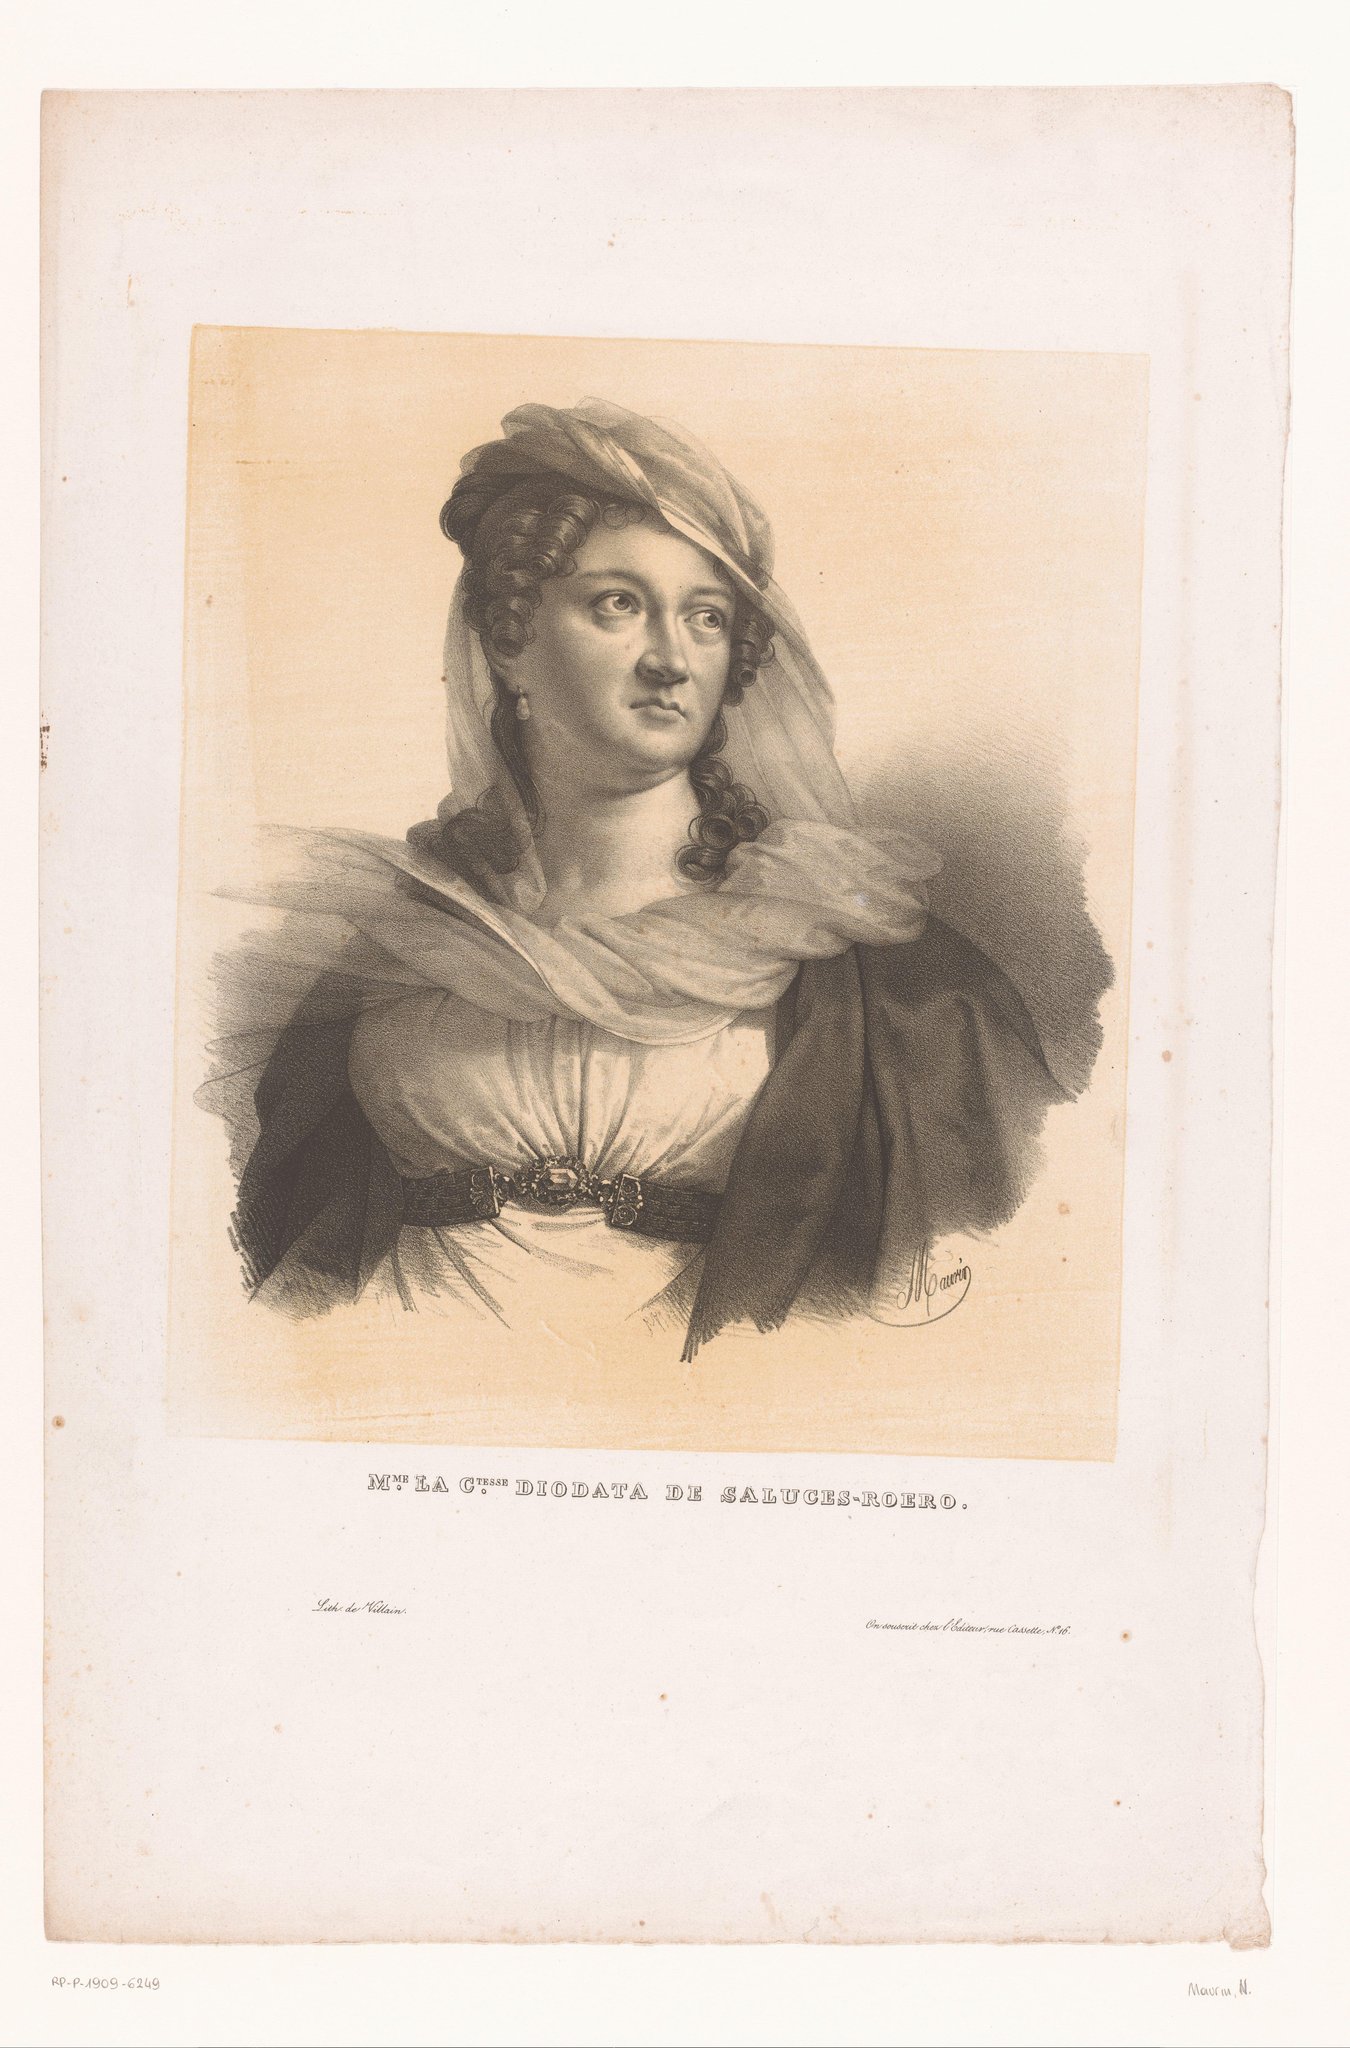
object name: print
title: Mme. la ctesse. Diodata de Saluces-Roero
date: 1827-1852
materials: paper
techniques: tone lithography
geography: paris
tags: historical persons, writer, poet, author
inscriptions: check stamp: ‘JC’, collector's mark: Lugt 2228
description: Prent waarschijnlijk ook gebruikt in: Chabert, Jean Claude. Galerie des contemporaines, ou collection de portraits des femmes qui se sont rendues célèbres depuis la fin du dix-huitième siècle, en France et dans les pays étrangers. Avec des notices historiques / Galerie des contemporaines ou collection de portraits et biographies des femmes, qui se sont rendues célébres, depuis la fin du dix-huitième siècle, soit en France, soit dans les pays étrangers. Parijs: Jean Claude Chabert en Hennet fils, s.a. [1824-1827]. De samenstelling van tegenwoordig bekende en al dan niet gebonden exemplaren van deze uitgaven verschillen. Dit omdat de prenten en bijhorende stukken tekst op inschrijving en waarschijnlijk ook los verkrijgbaar waren.